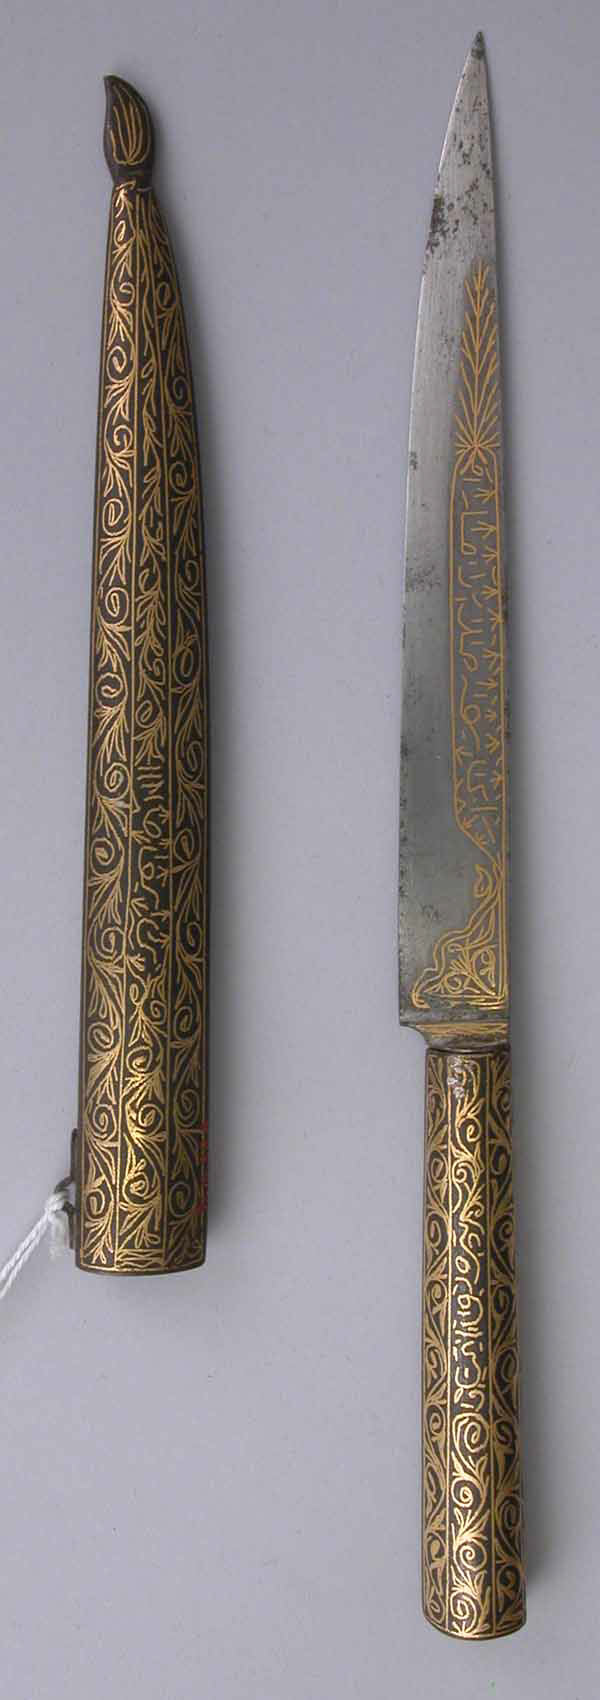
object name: knife with sheath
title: Knife and Sheath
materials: gold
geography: india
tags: knives